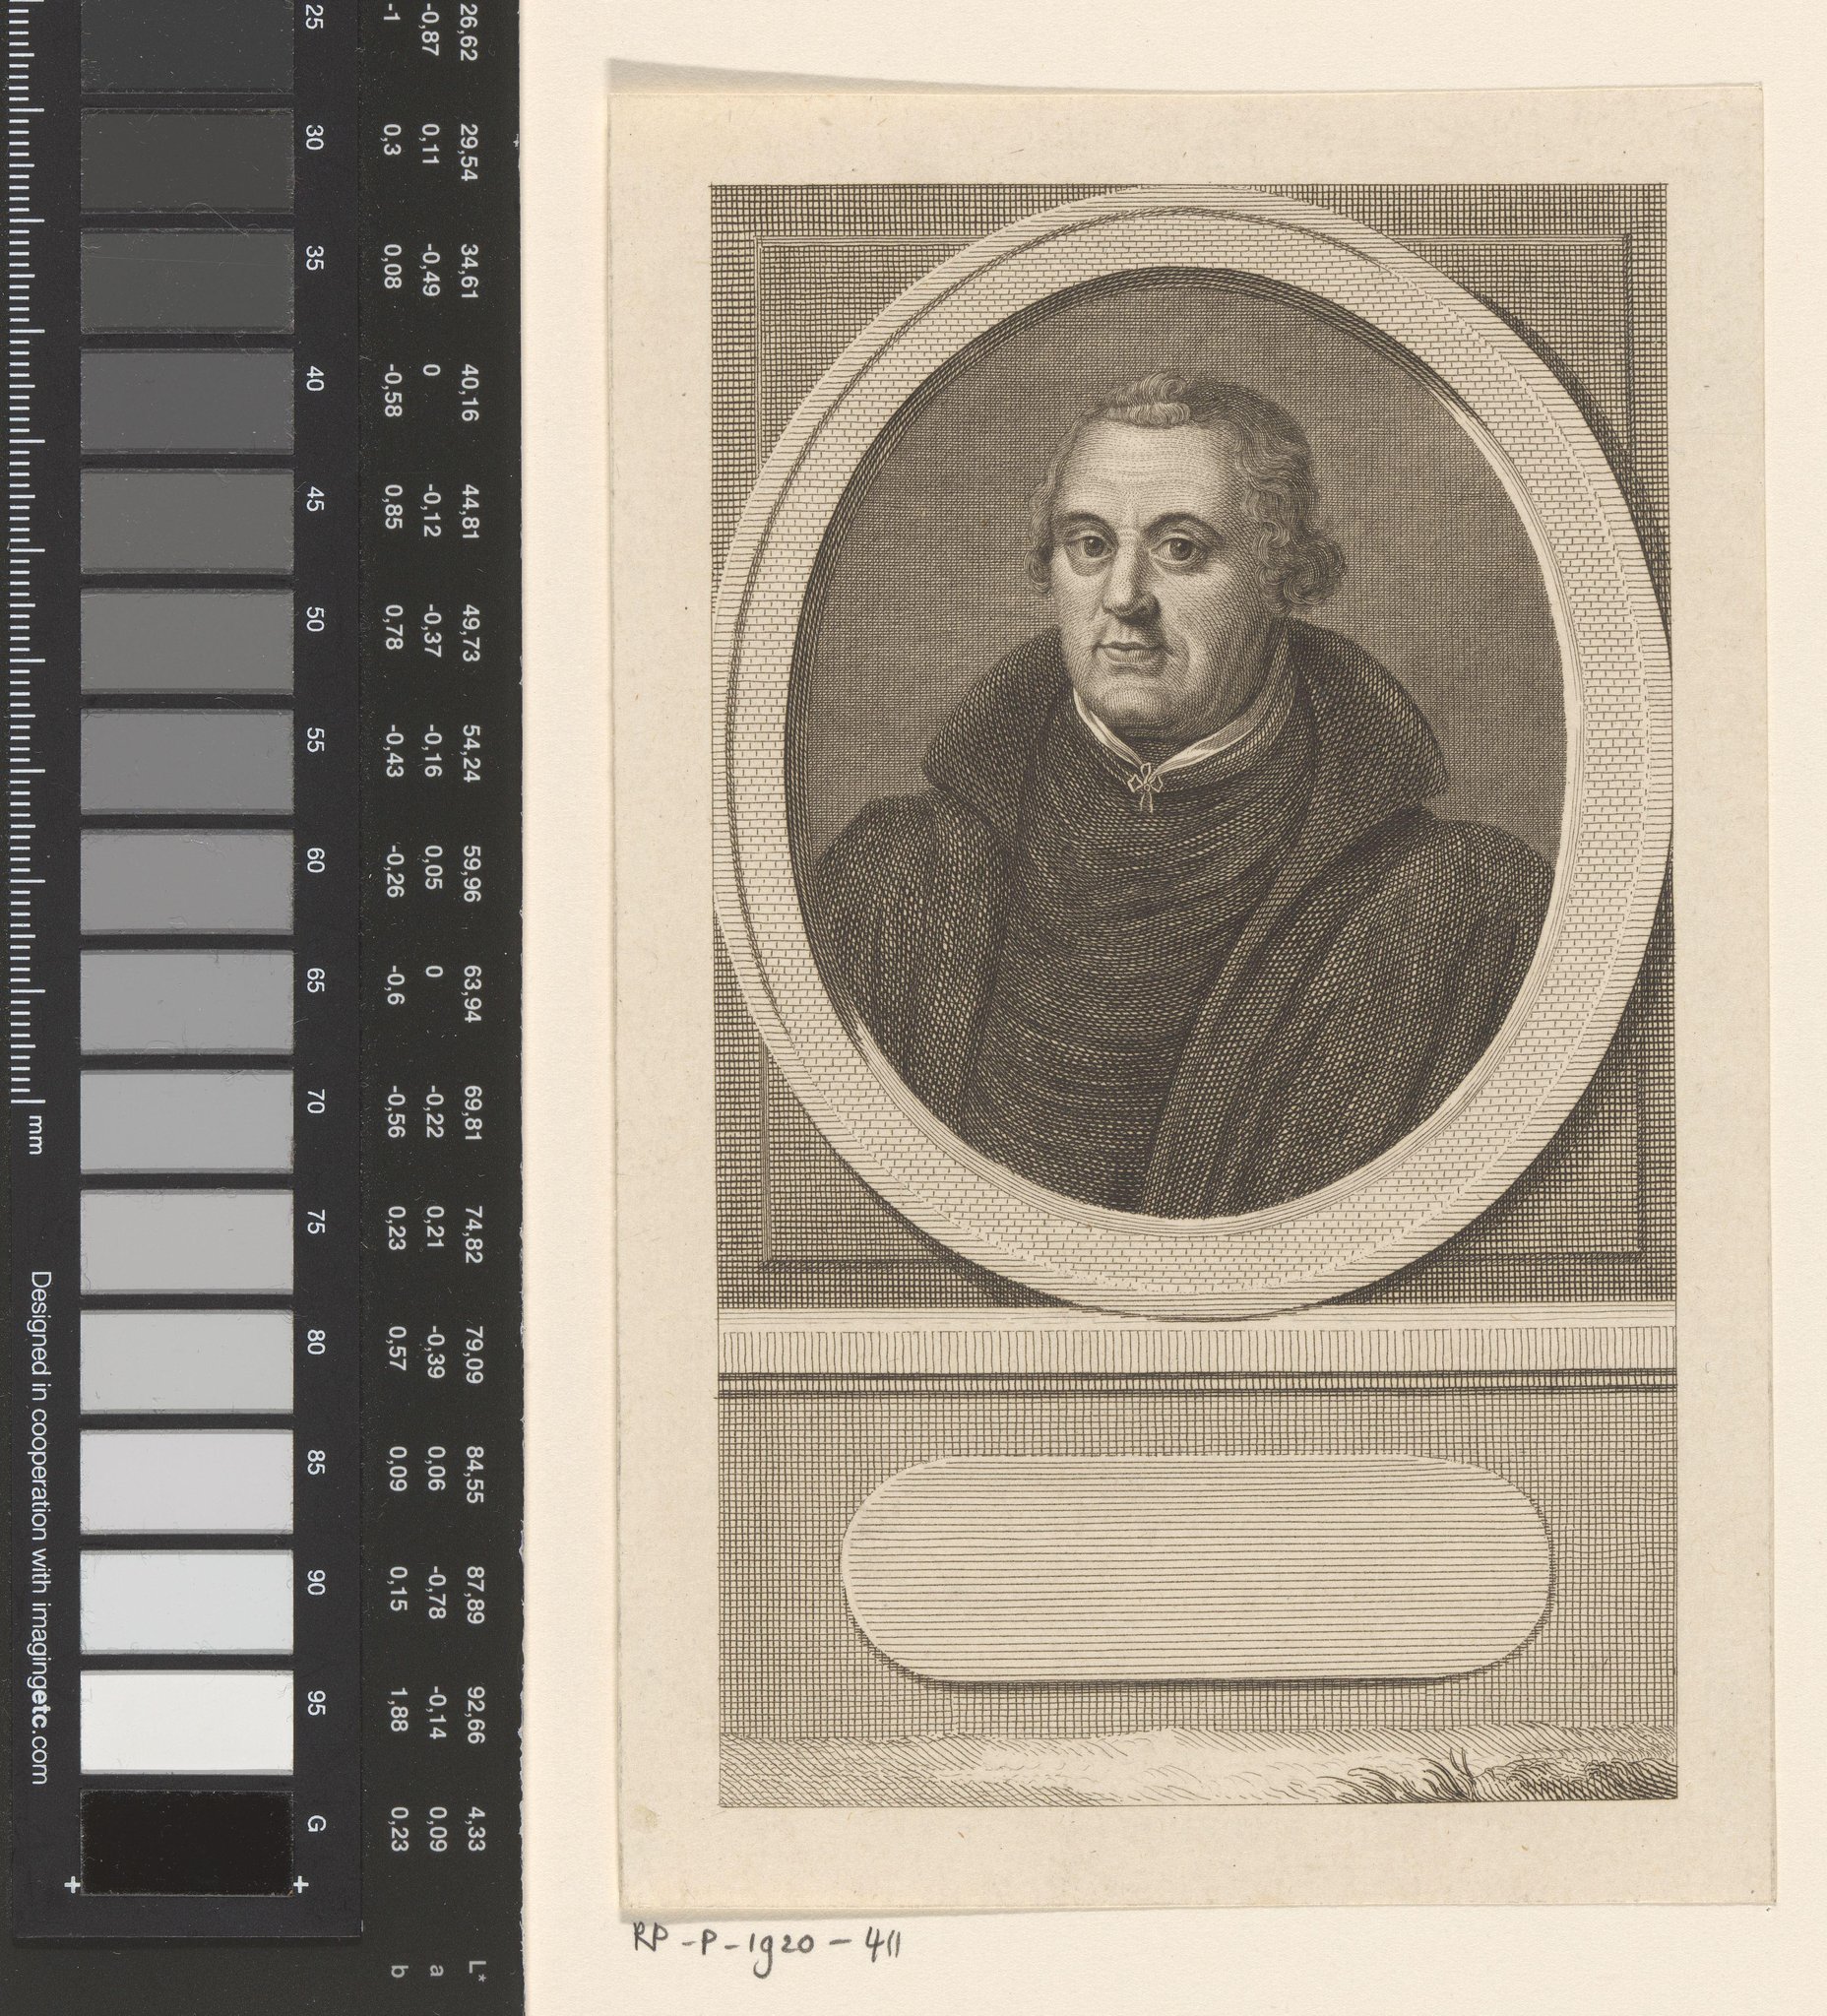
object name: print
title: Portret van de hervormer Martin Luther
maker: reinier vinkeles (i)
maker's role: draughtsman, print maker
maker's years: 1741-1816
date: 1751-1816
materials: paper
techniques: etching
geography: amsterdam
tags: priest, martin luther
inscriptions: collector's mark: Lugt 2228